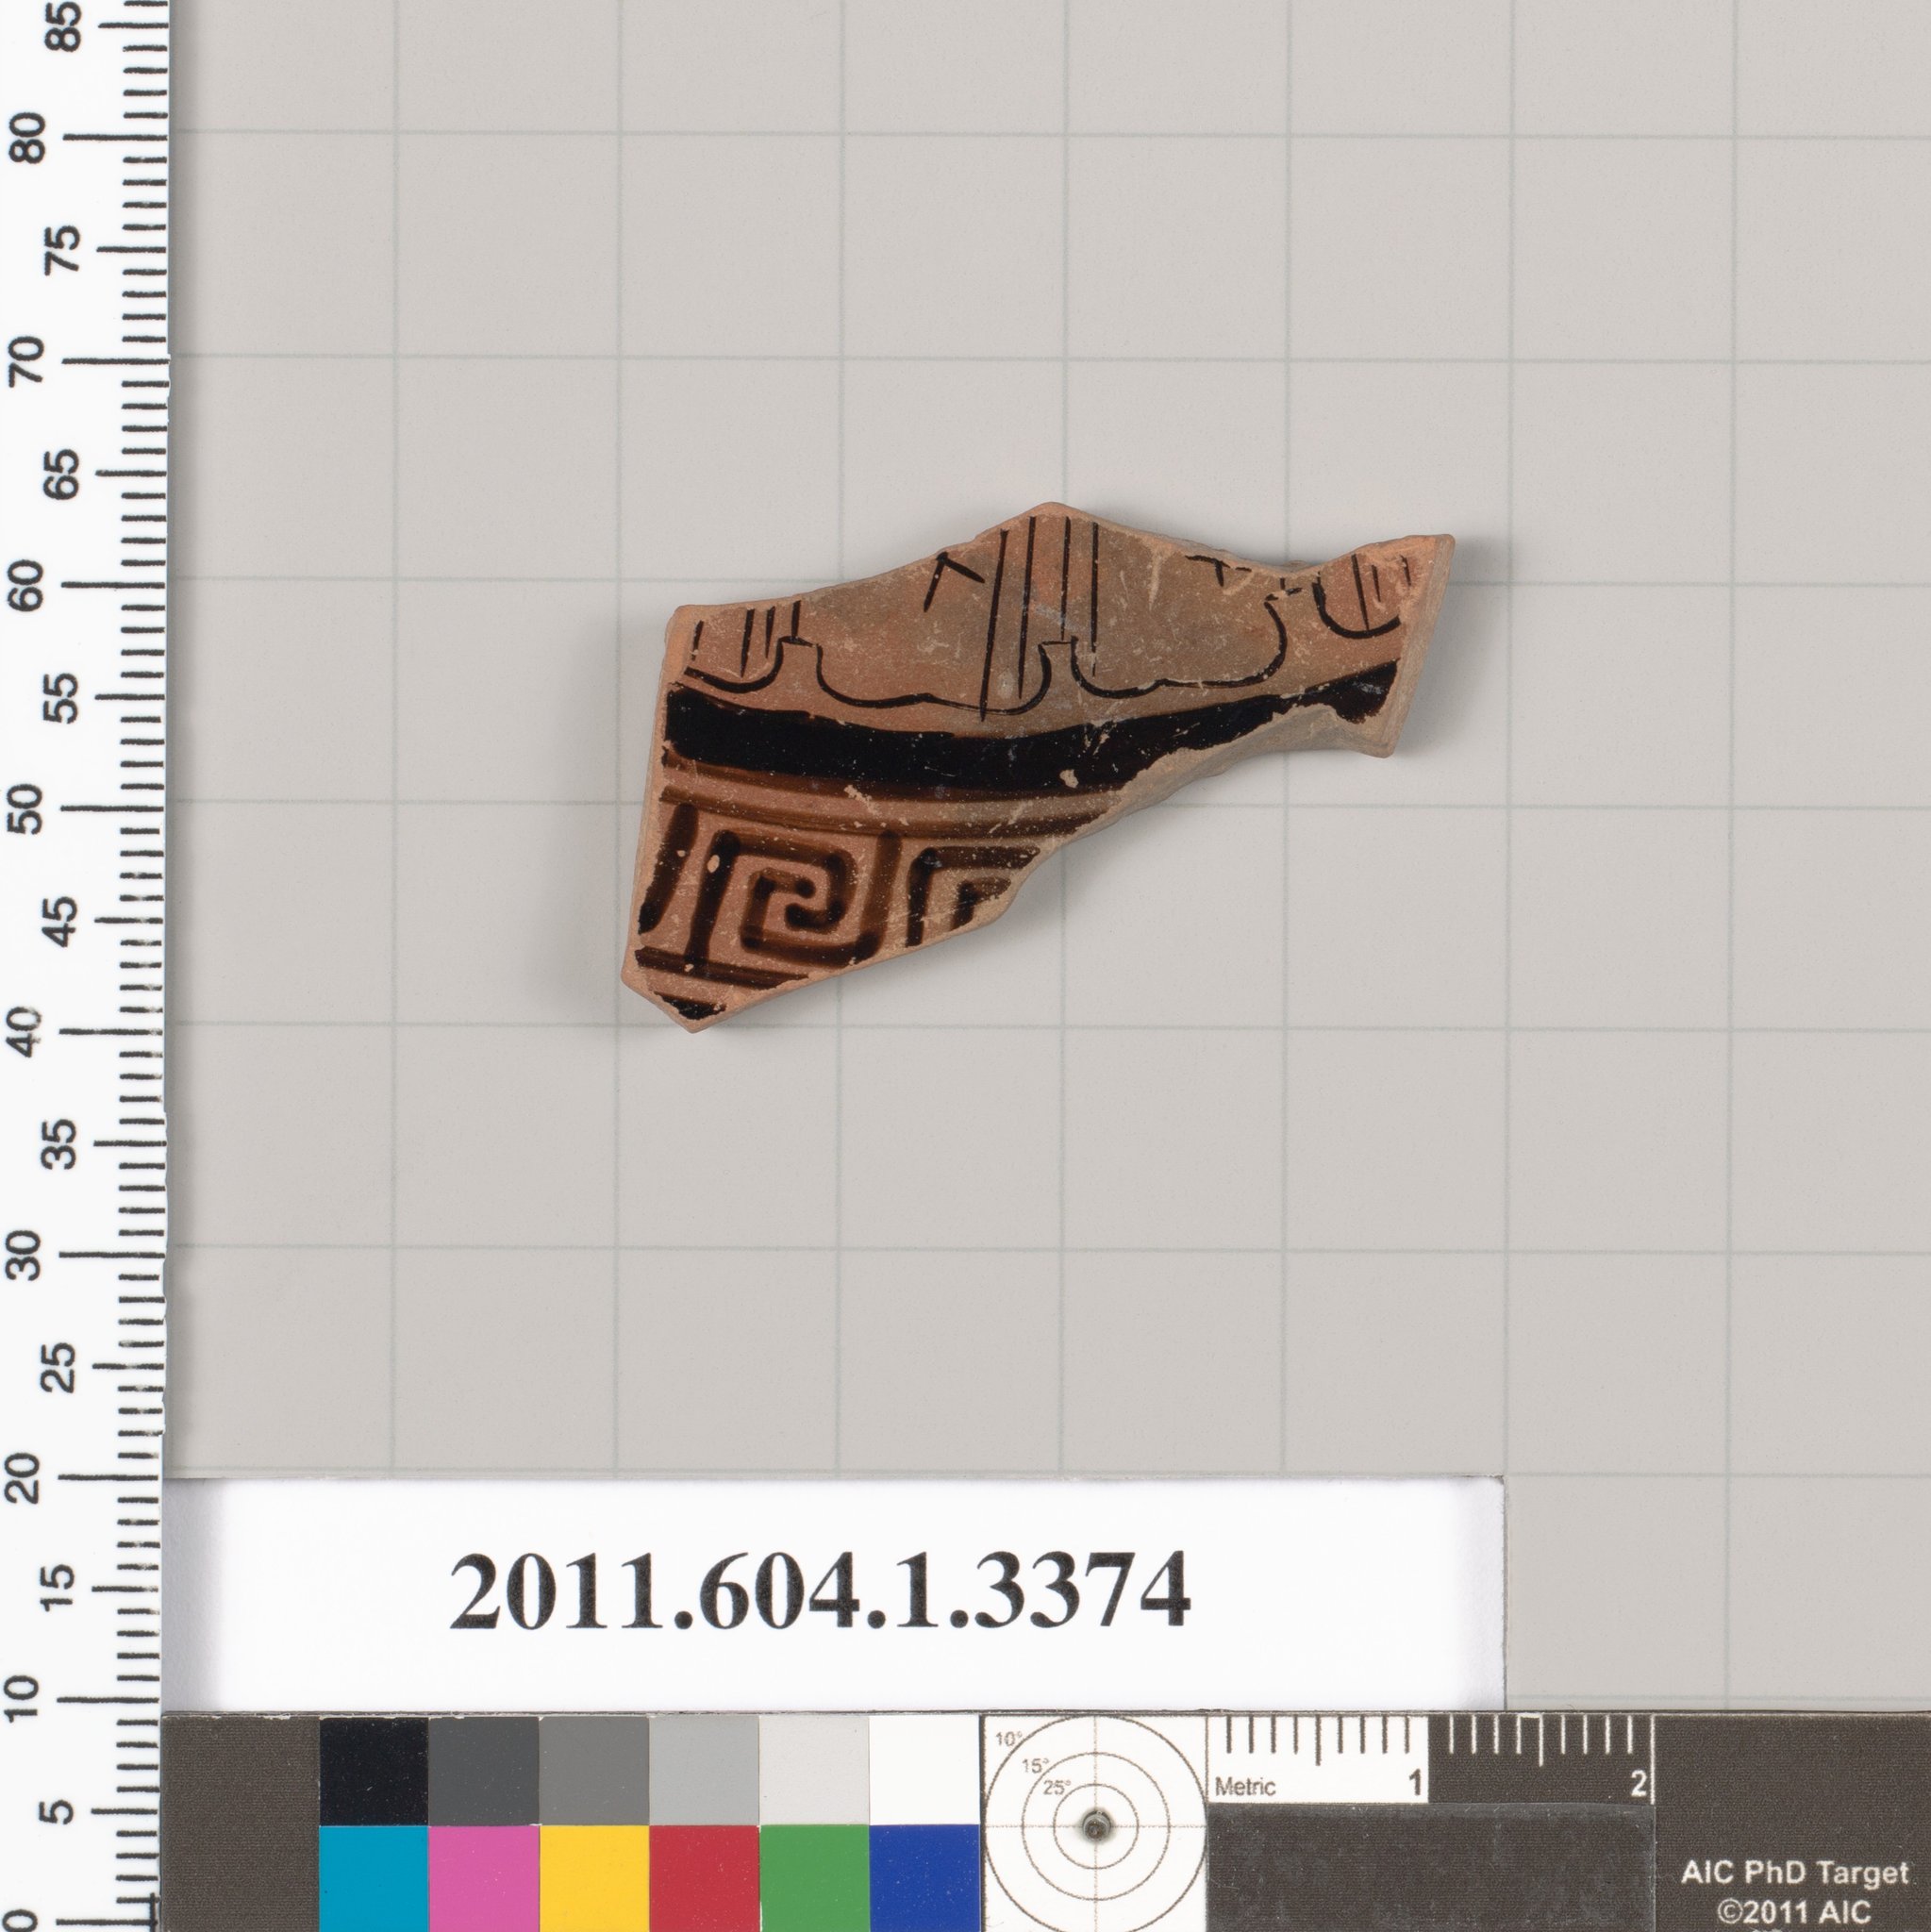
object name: kylix fragment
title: Terracotta fragment of a kylix (drinking cup)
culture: greek, attic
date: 490-480 BCE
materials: terracotta